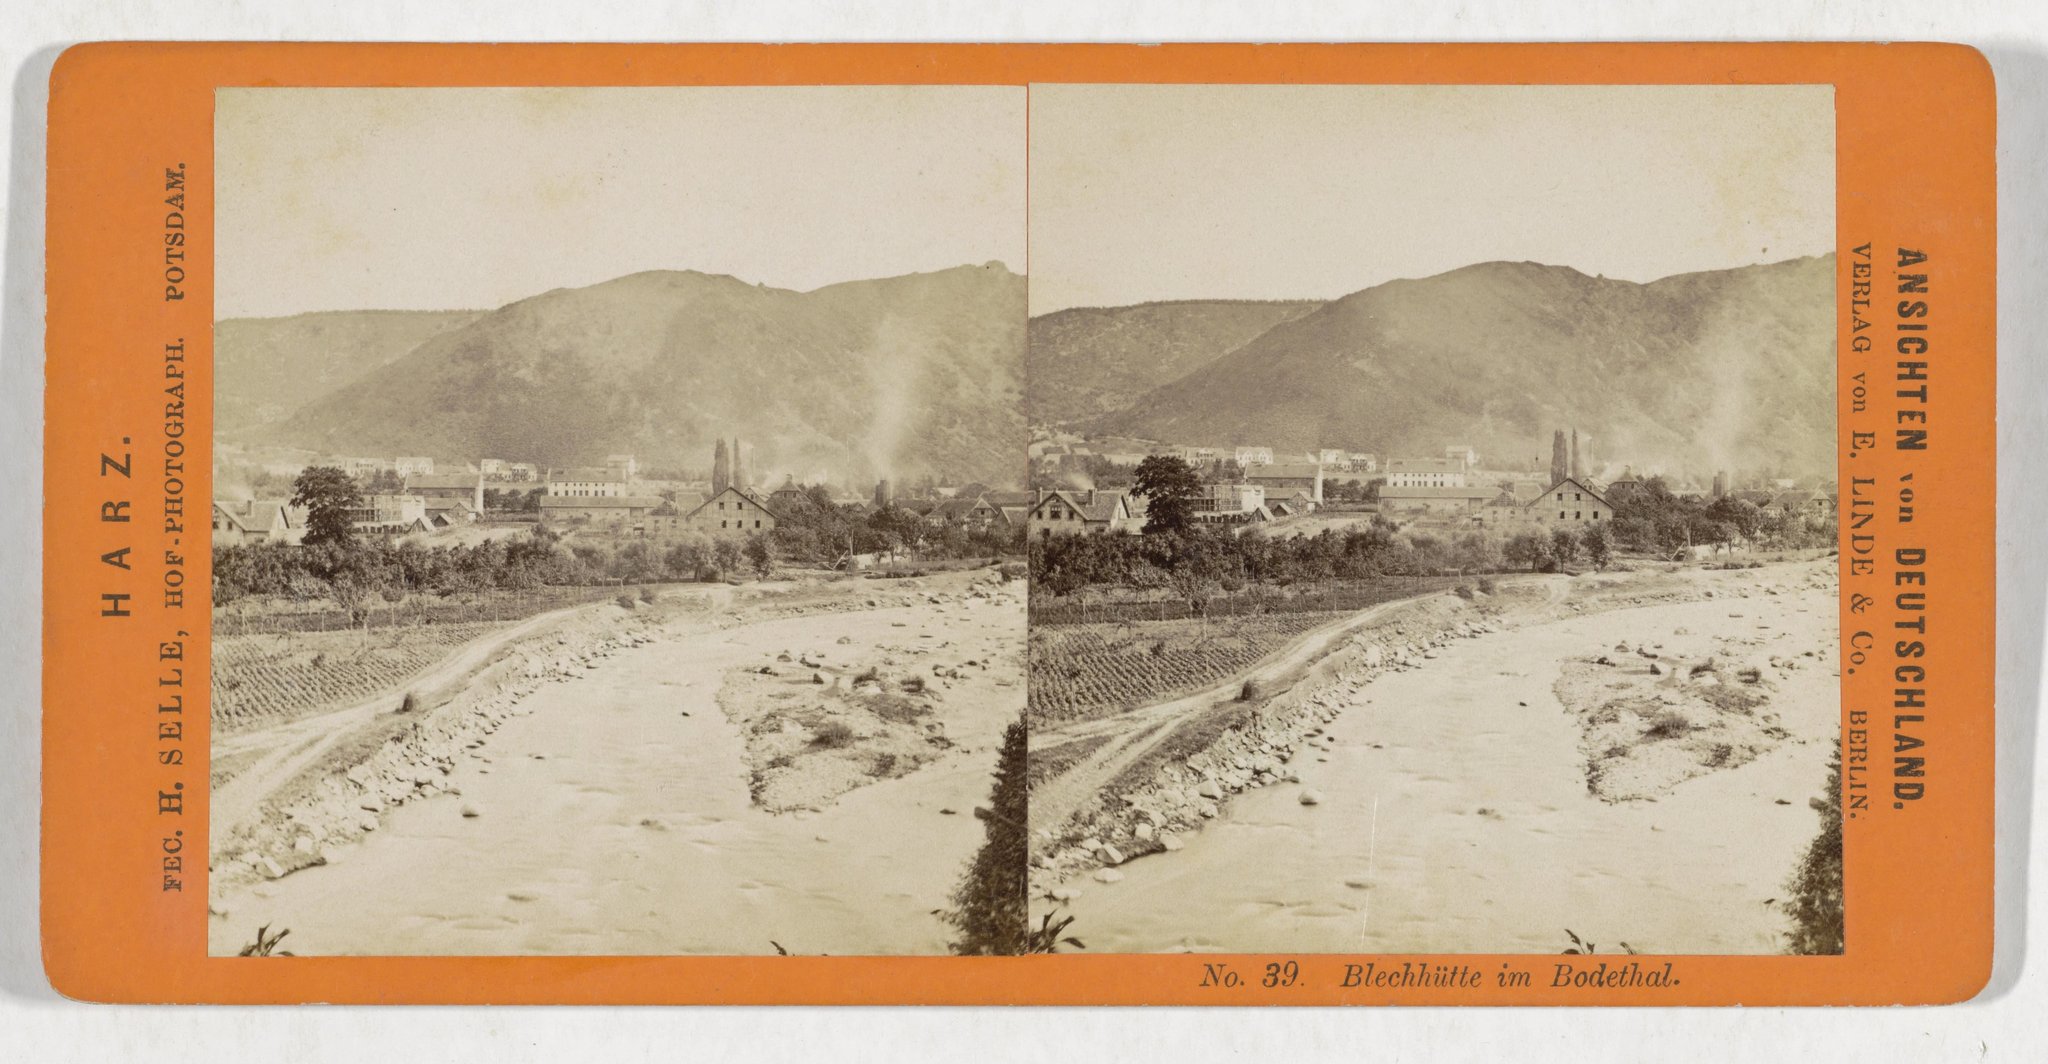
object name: stereograph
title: Blechhütte im Bodethal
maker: hermann selle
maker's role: fotograaf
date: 1868-1890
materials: cardboard, paper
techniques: albumen print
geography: thale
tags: prospect of village, silhouette of village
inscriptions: number: ‘No. 39.’